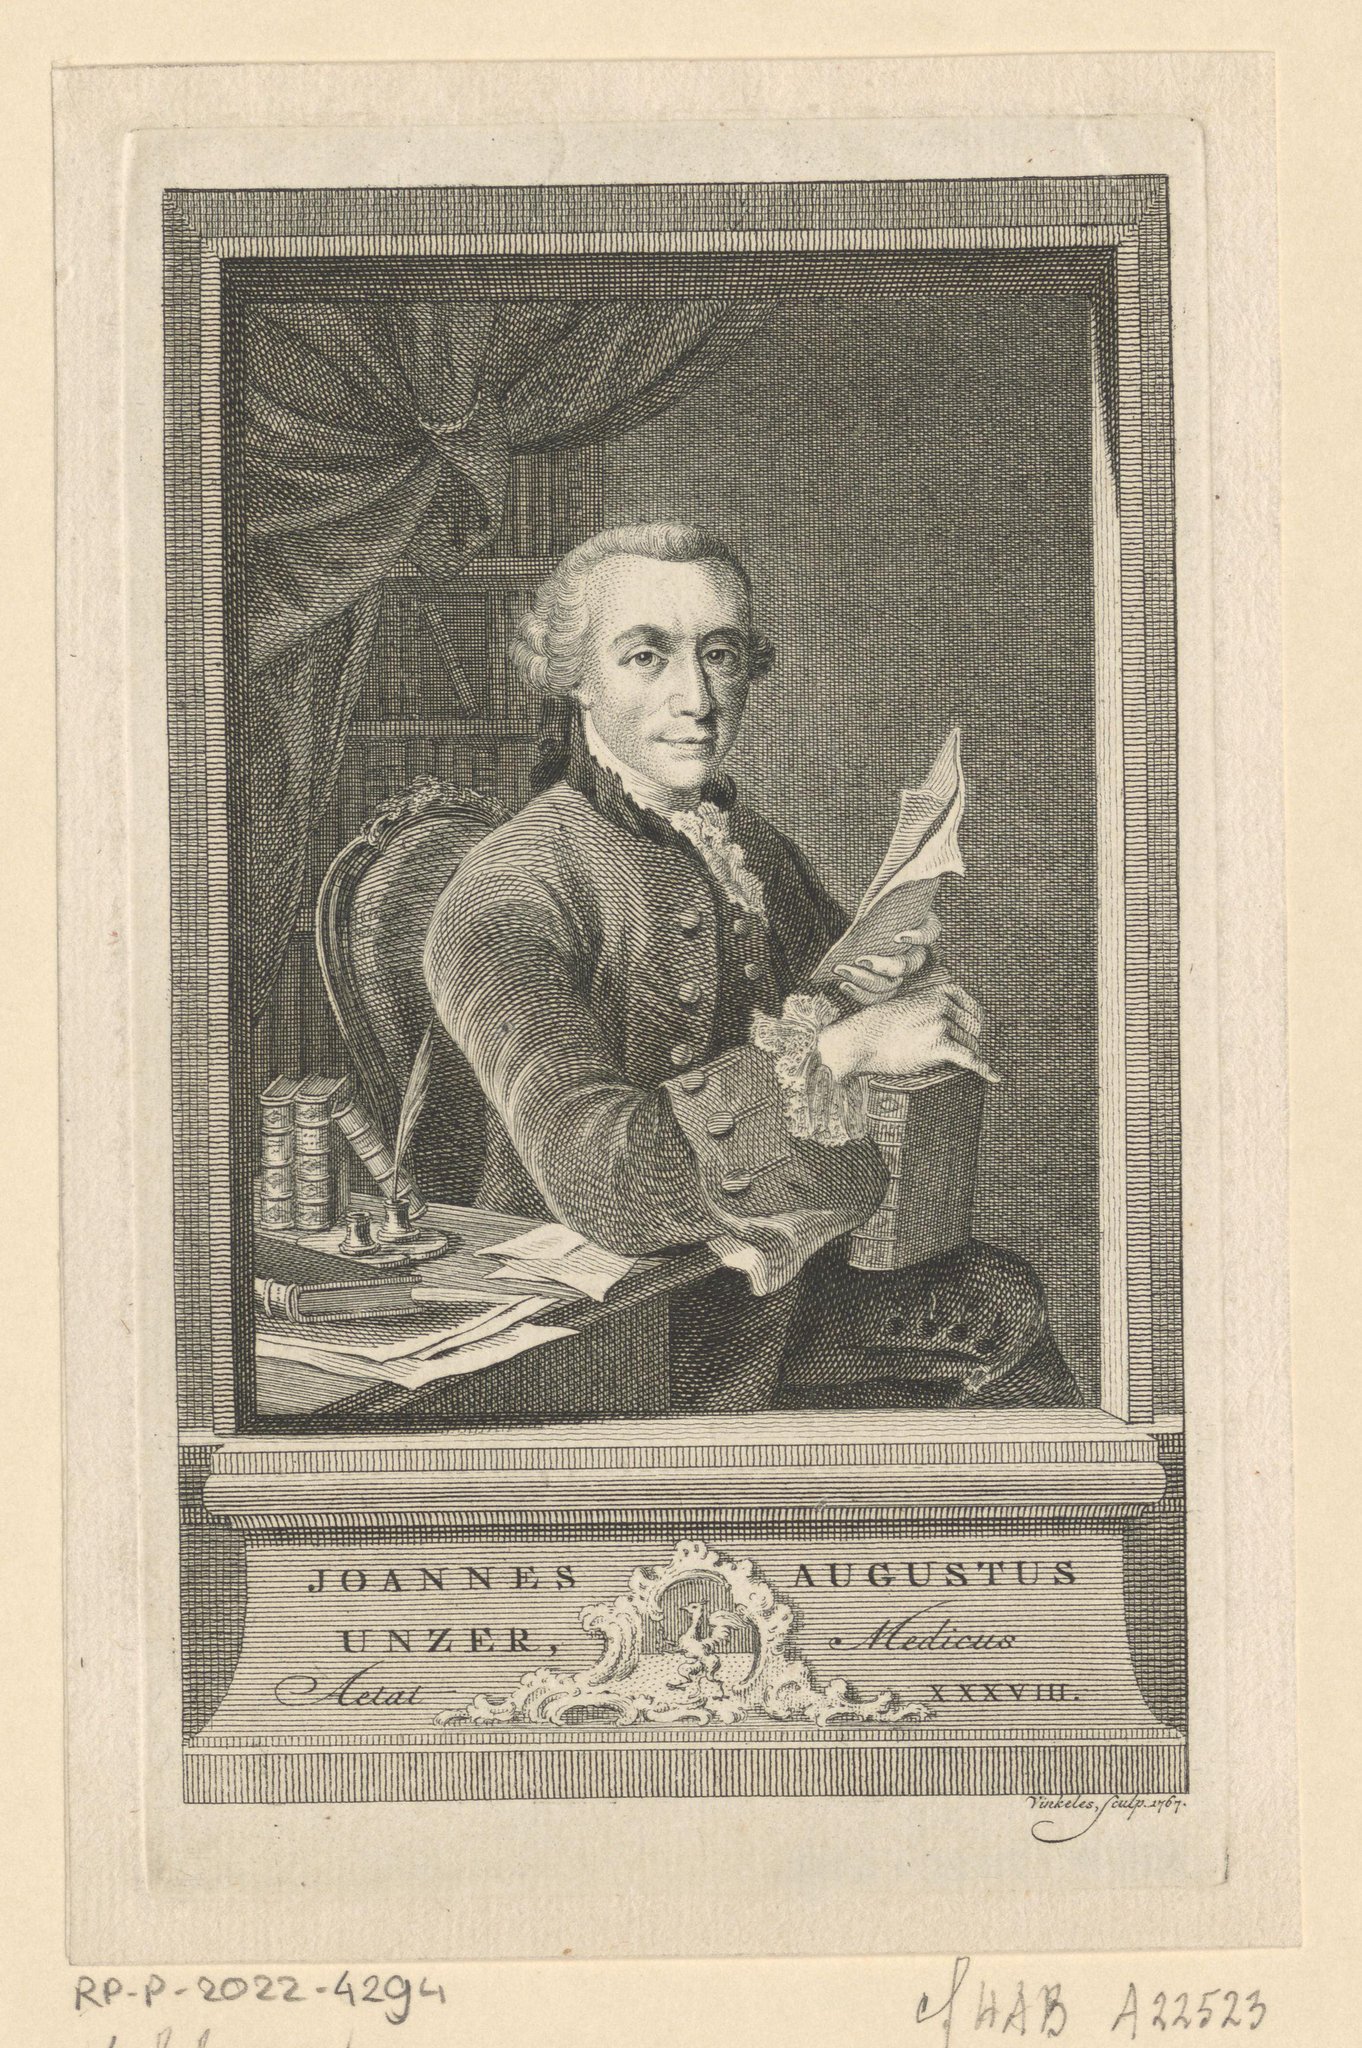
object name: print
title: Portret van Johann August Unzer op 38-jarige leeftijd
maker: reinier vinkeles (i)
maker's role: draughtsman, print maker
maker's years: 1741-1816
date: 1767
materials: paper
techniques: engraving, etching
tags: historical persons, physician, doctor